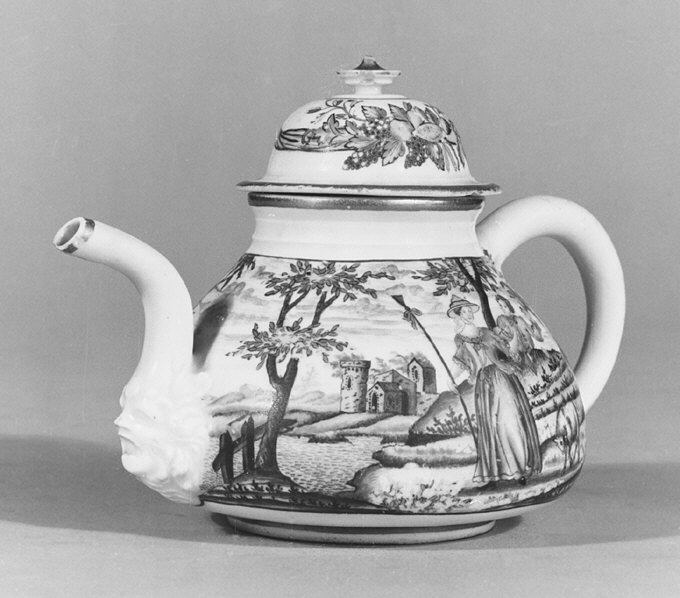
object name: teapot with cover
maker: meissen manufactory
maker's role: manufactory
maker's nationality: german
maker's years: 1710-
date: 1720-1740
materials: hard paste porcelain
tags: houses,women,landscapes,trees